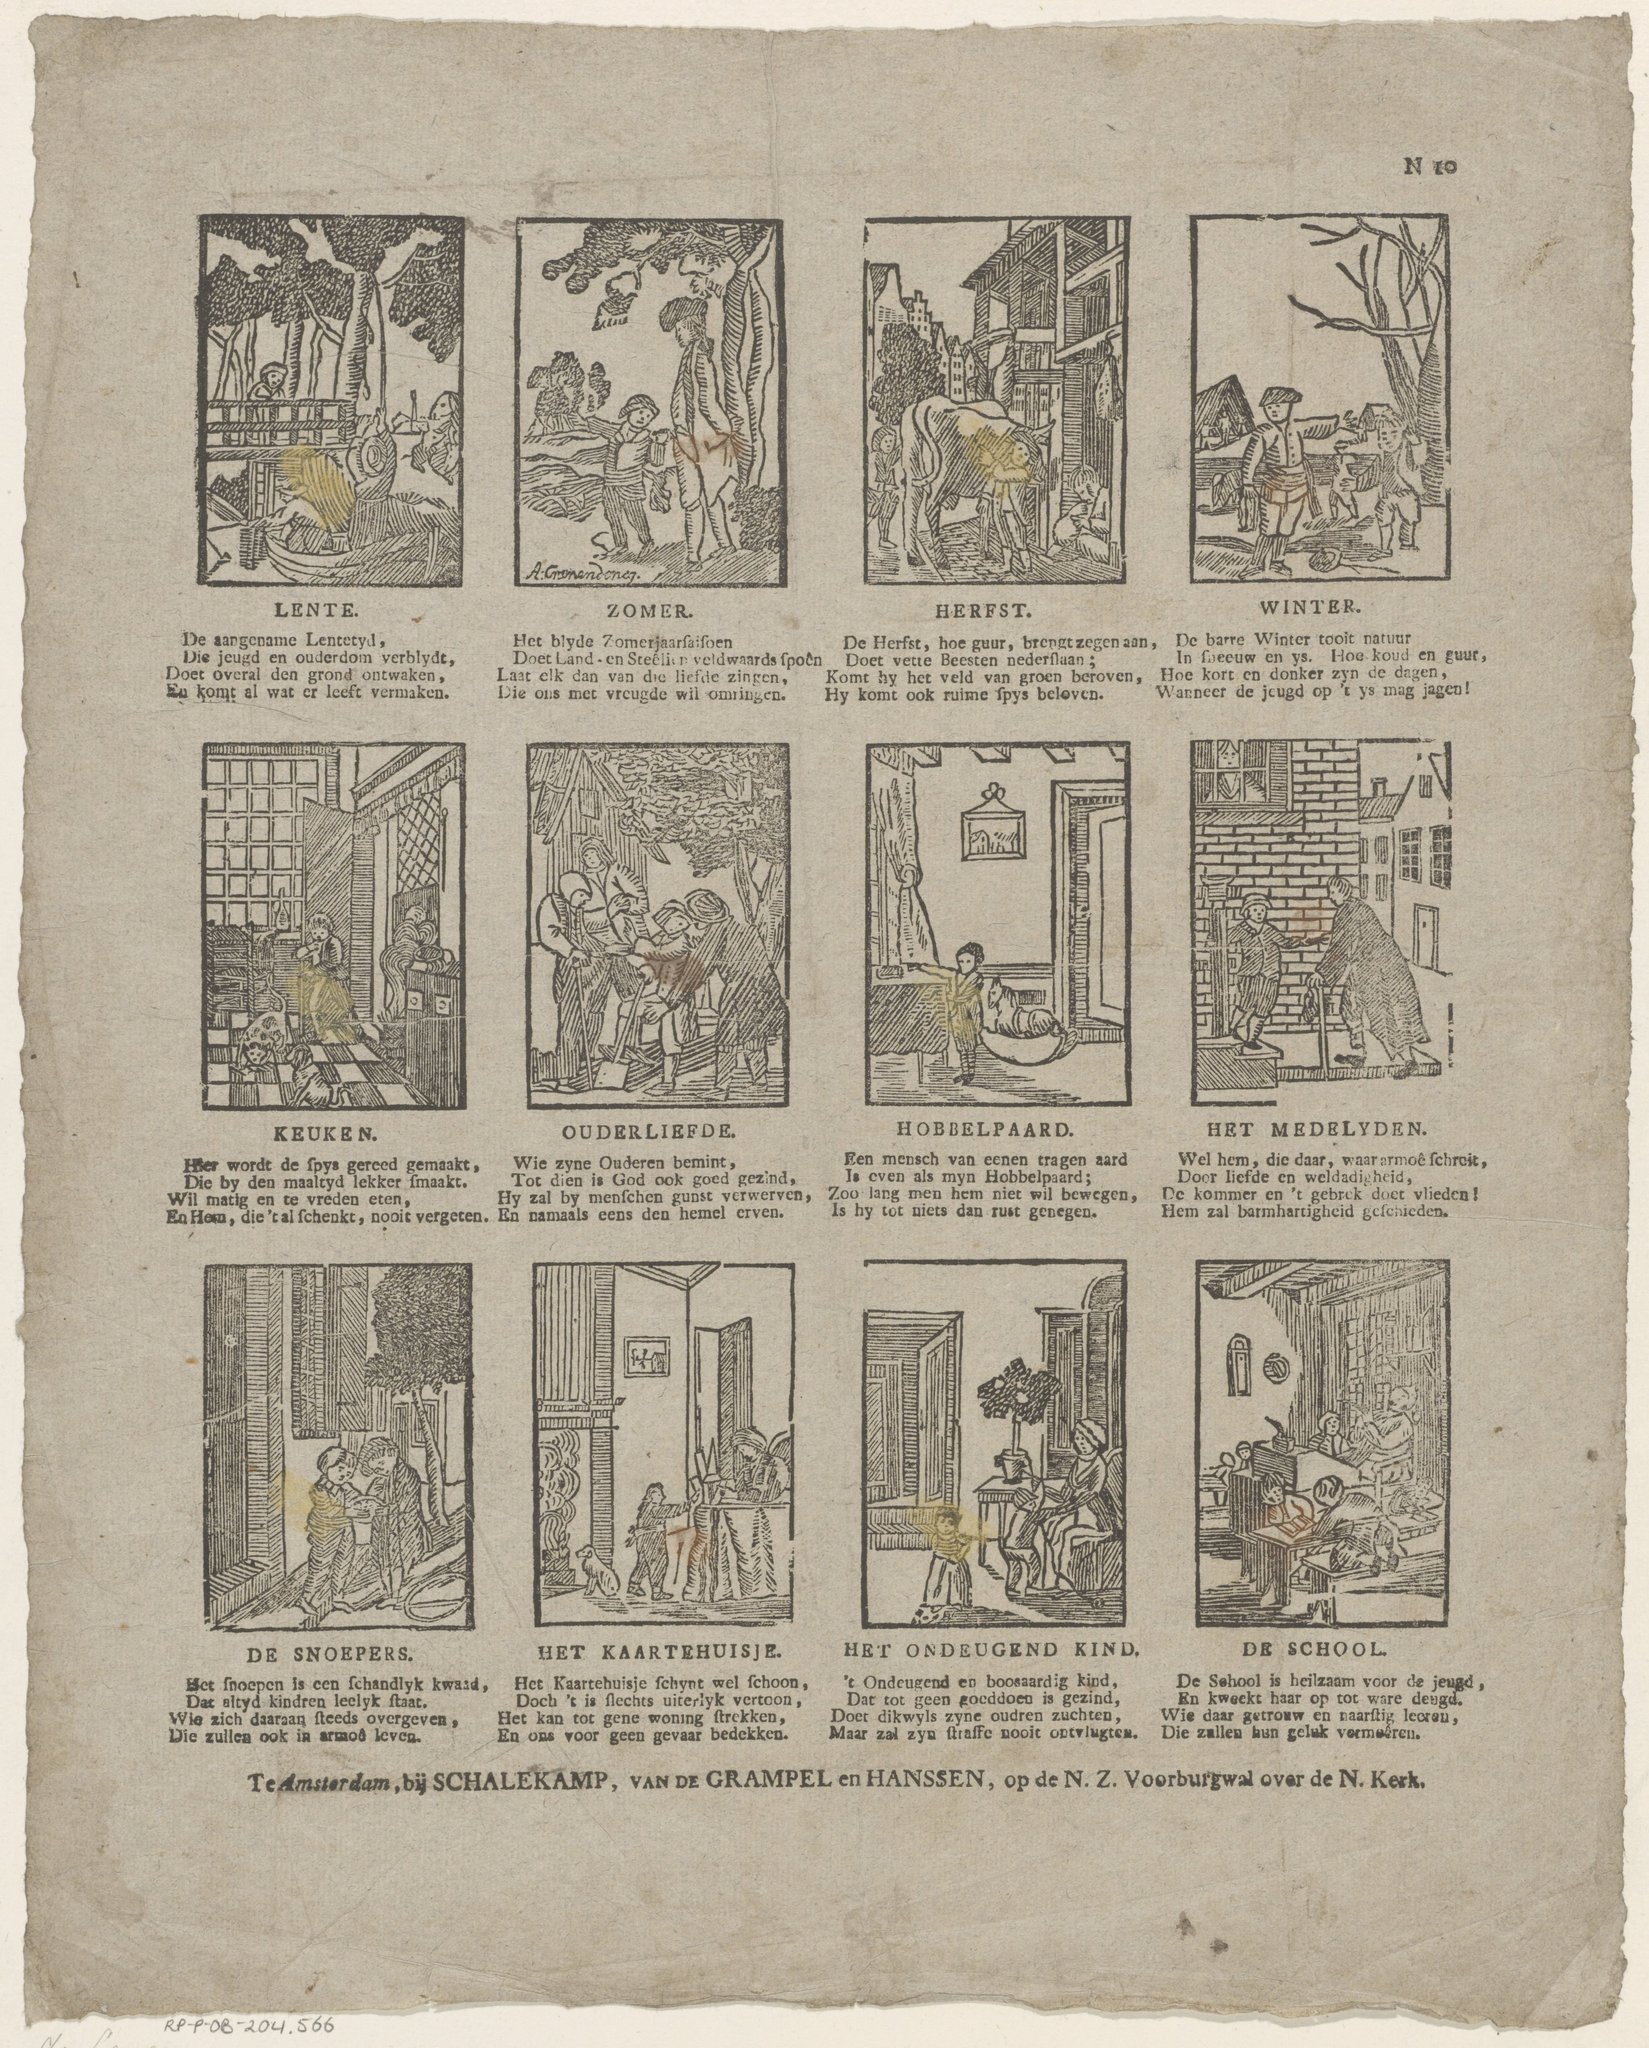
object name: popular print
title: Verschillende taferelen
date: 1822-1849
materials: paper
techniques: colour, letterpress printing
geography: deventer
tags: kitchen, child, bad behaviour, rocking-horse, the four seasons of the year ~ human activities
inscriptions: collector's mark: Lugt 2760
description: Blad met 12 voorstellingen van verschillende aard, waaronder verbeeldingen van de vier seizoenen en voorstellingen van een hobbelpaard en twee snoepende kinderen. Onder elke afbeelding een titel en een vierregelig vers. Genummerd rechtsboven: N 10.